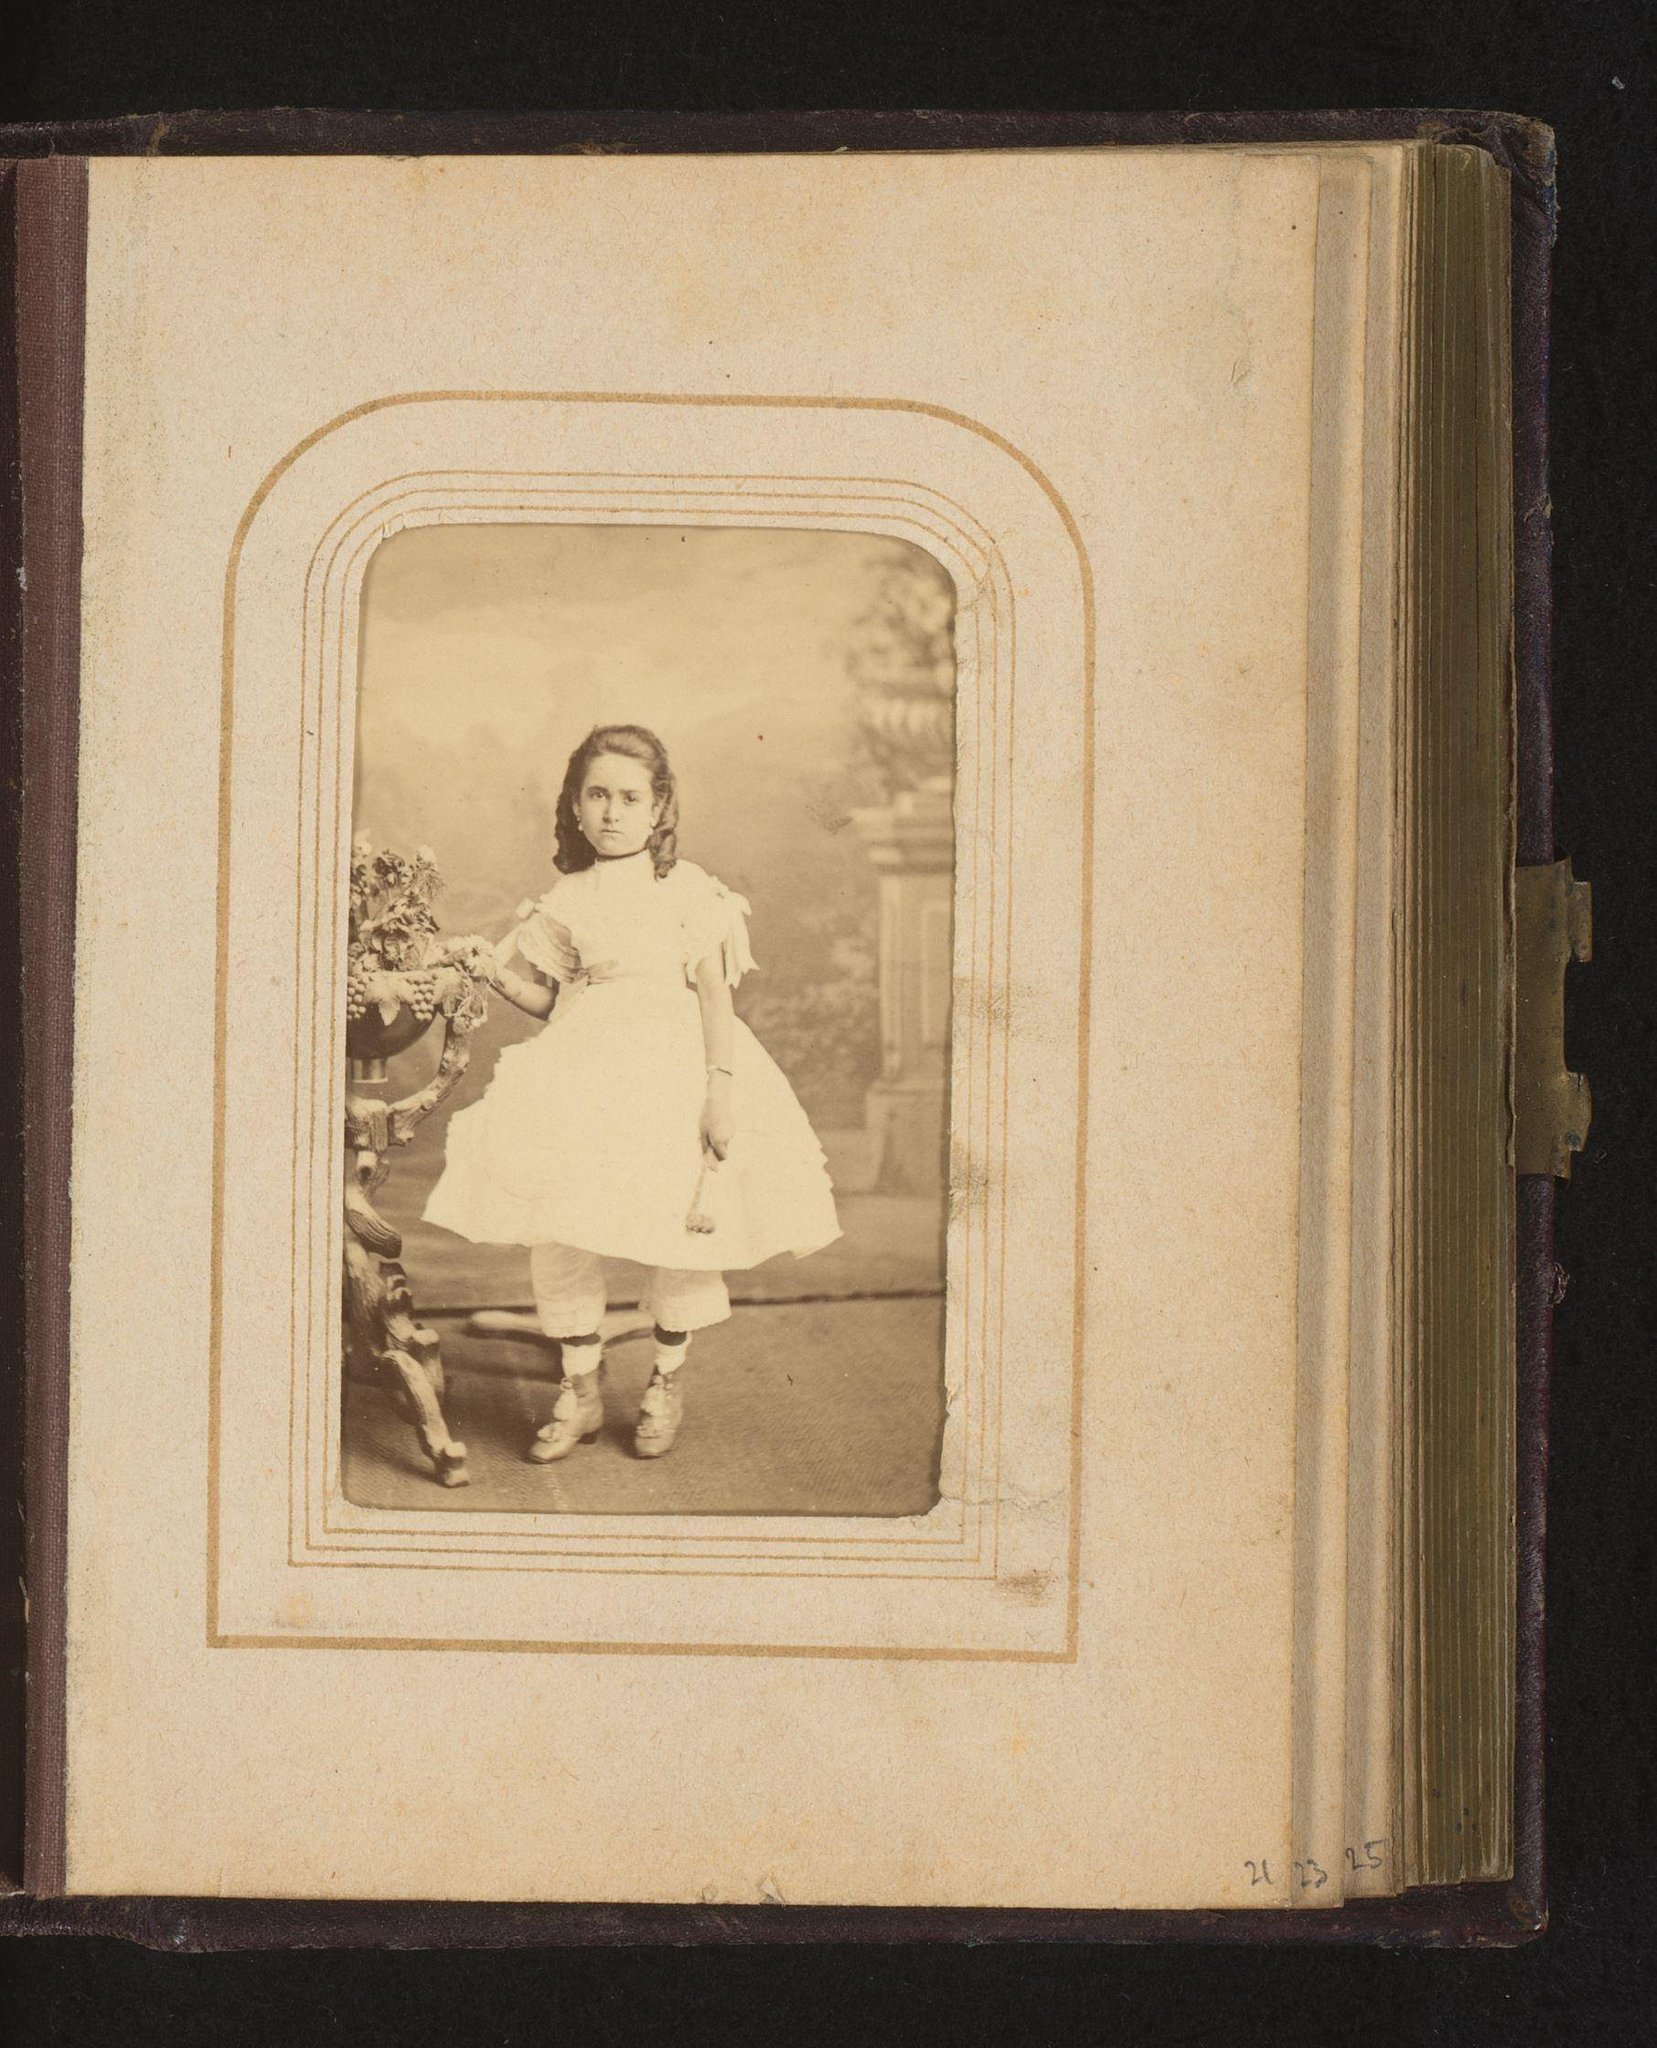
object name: carte de visite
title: Portret van een meisje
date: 1860-1900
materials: cardboard, photographic support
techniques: albumen print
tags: girl (child between toddler and youth)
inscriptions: inscription: ‘S.A. Cohner/ Calle de O'Reilly, 62, Habana/ Rue de Rivoli, 79, Paris’